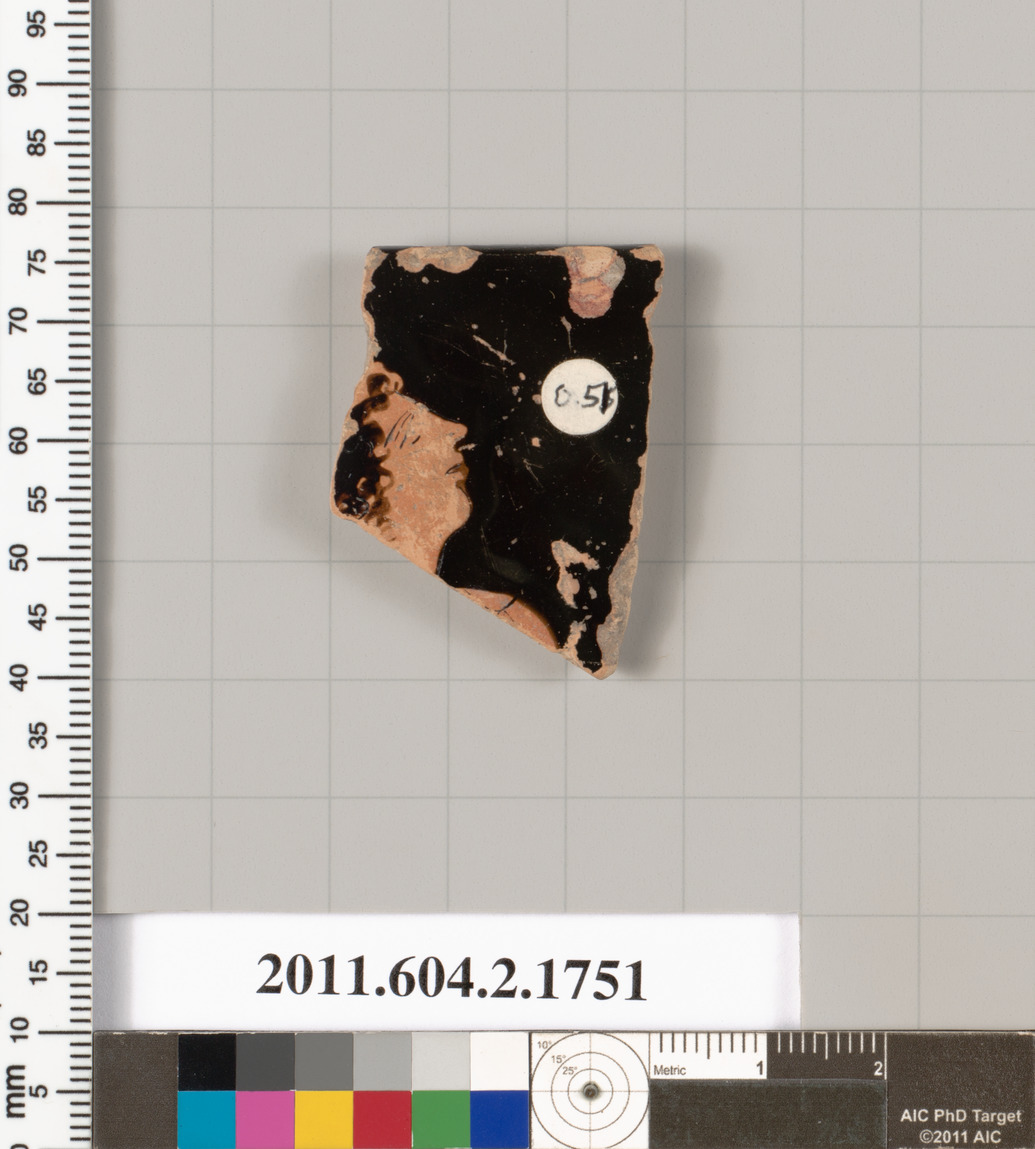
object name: skyphos fragment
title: Terracotta rim fragment of a skyphos (deep drinking cup)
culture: greek, attic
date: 450-426 BCE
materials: terracotta